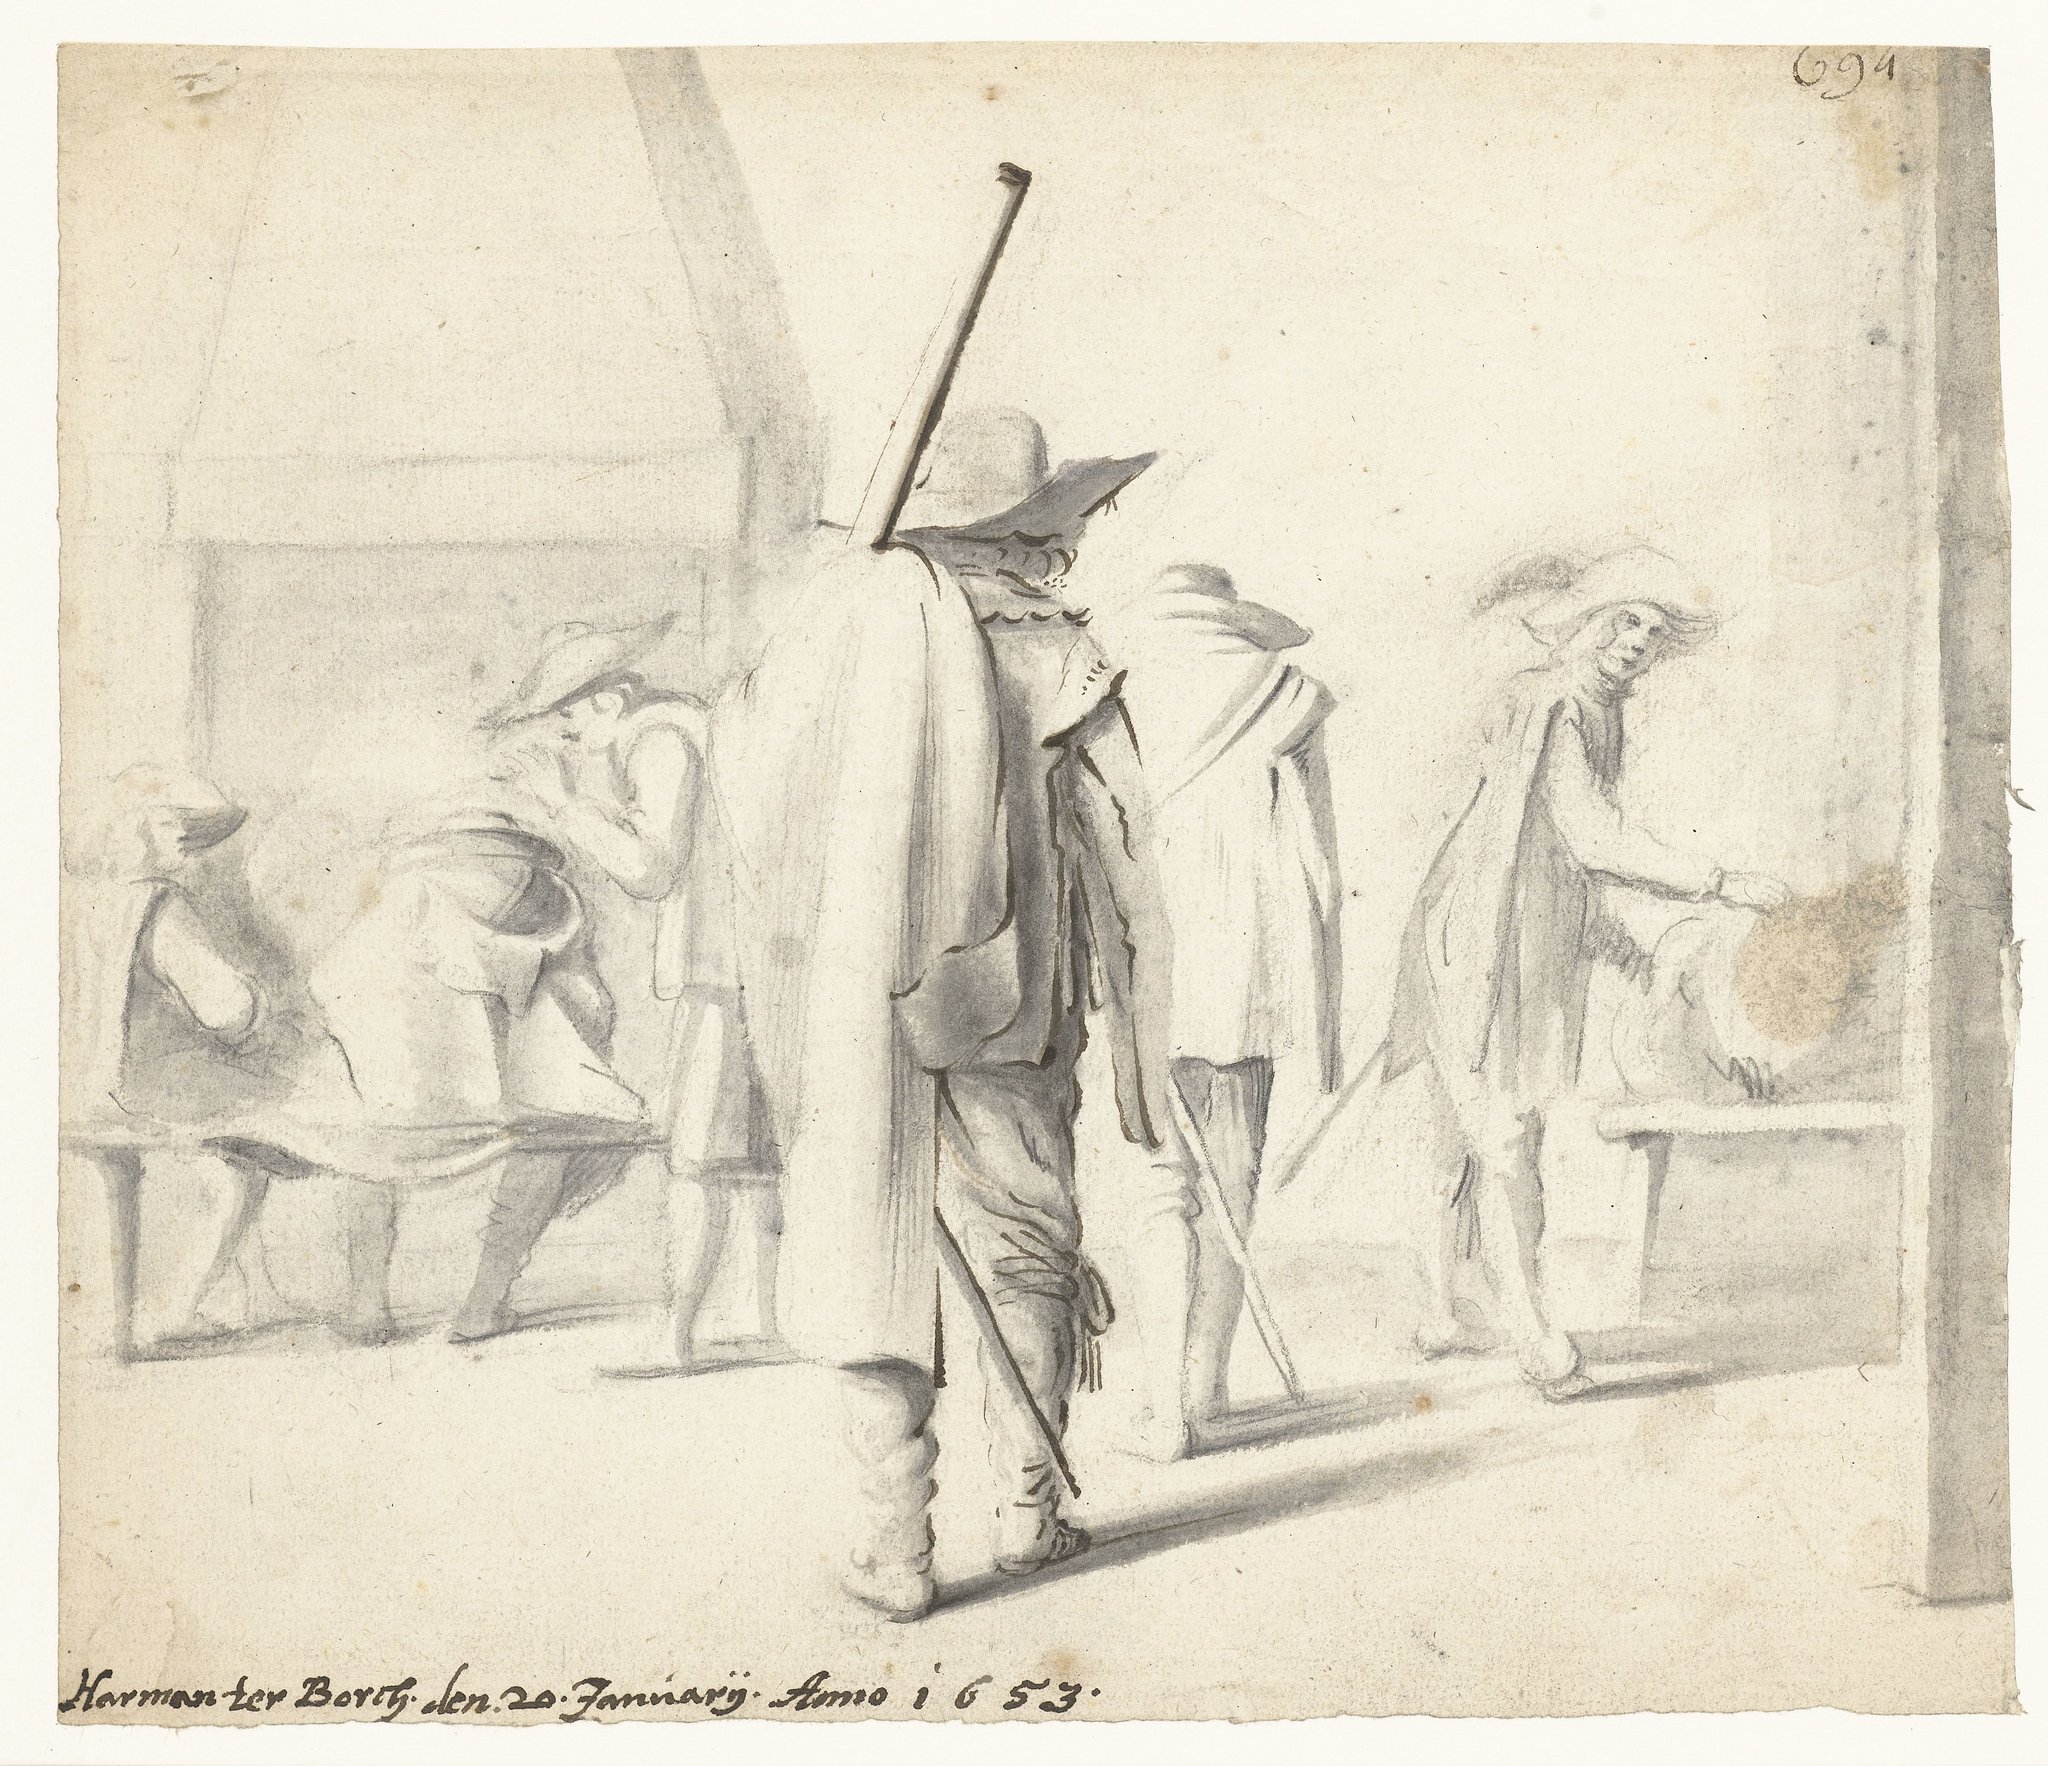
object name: drawing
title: Zes soldaten in een interieur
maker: harmen ter borch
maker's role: draughtsman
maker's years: 1638-1677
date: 1653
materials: chalk, ink, paper, pencil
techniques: brush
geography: zwolle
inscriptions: annotation: ‘Harman ter Borch. den.20.Januarij. Anno 1653.’